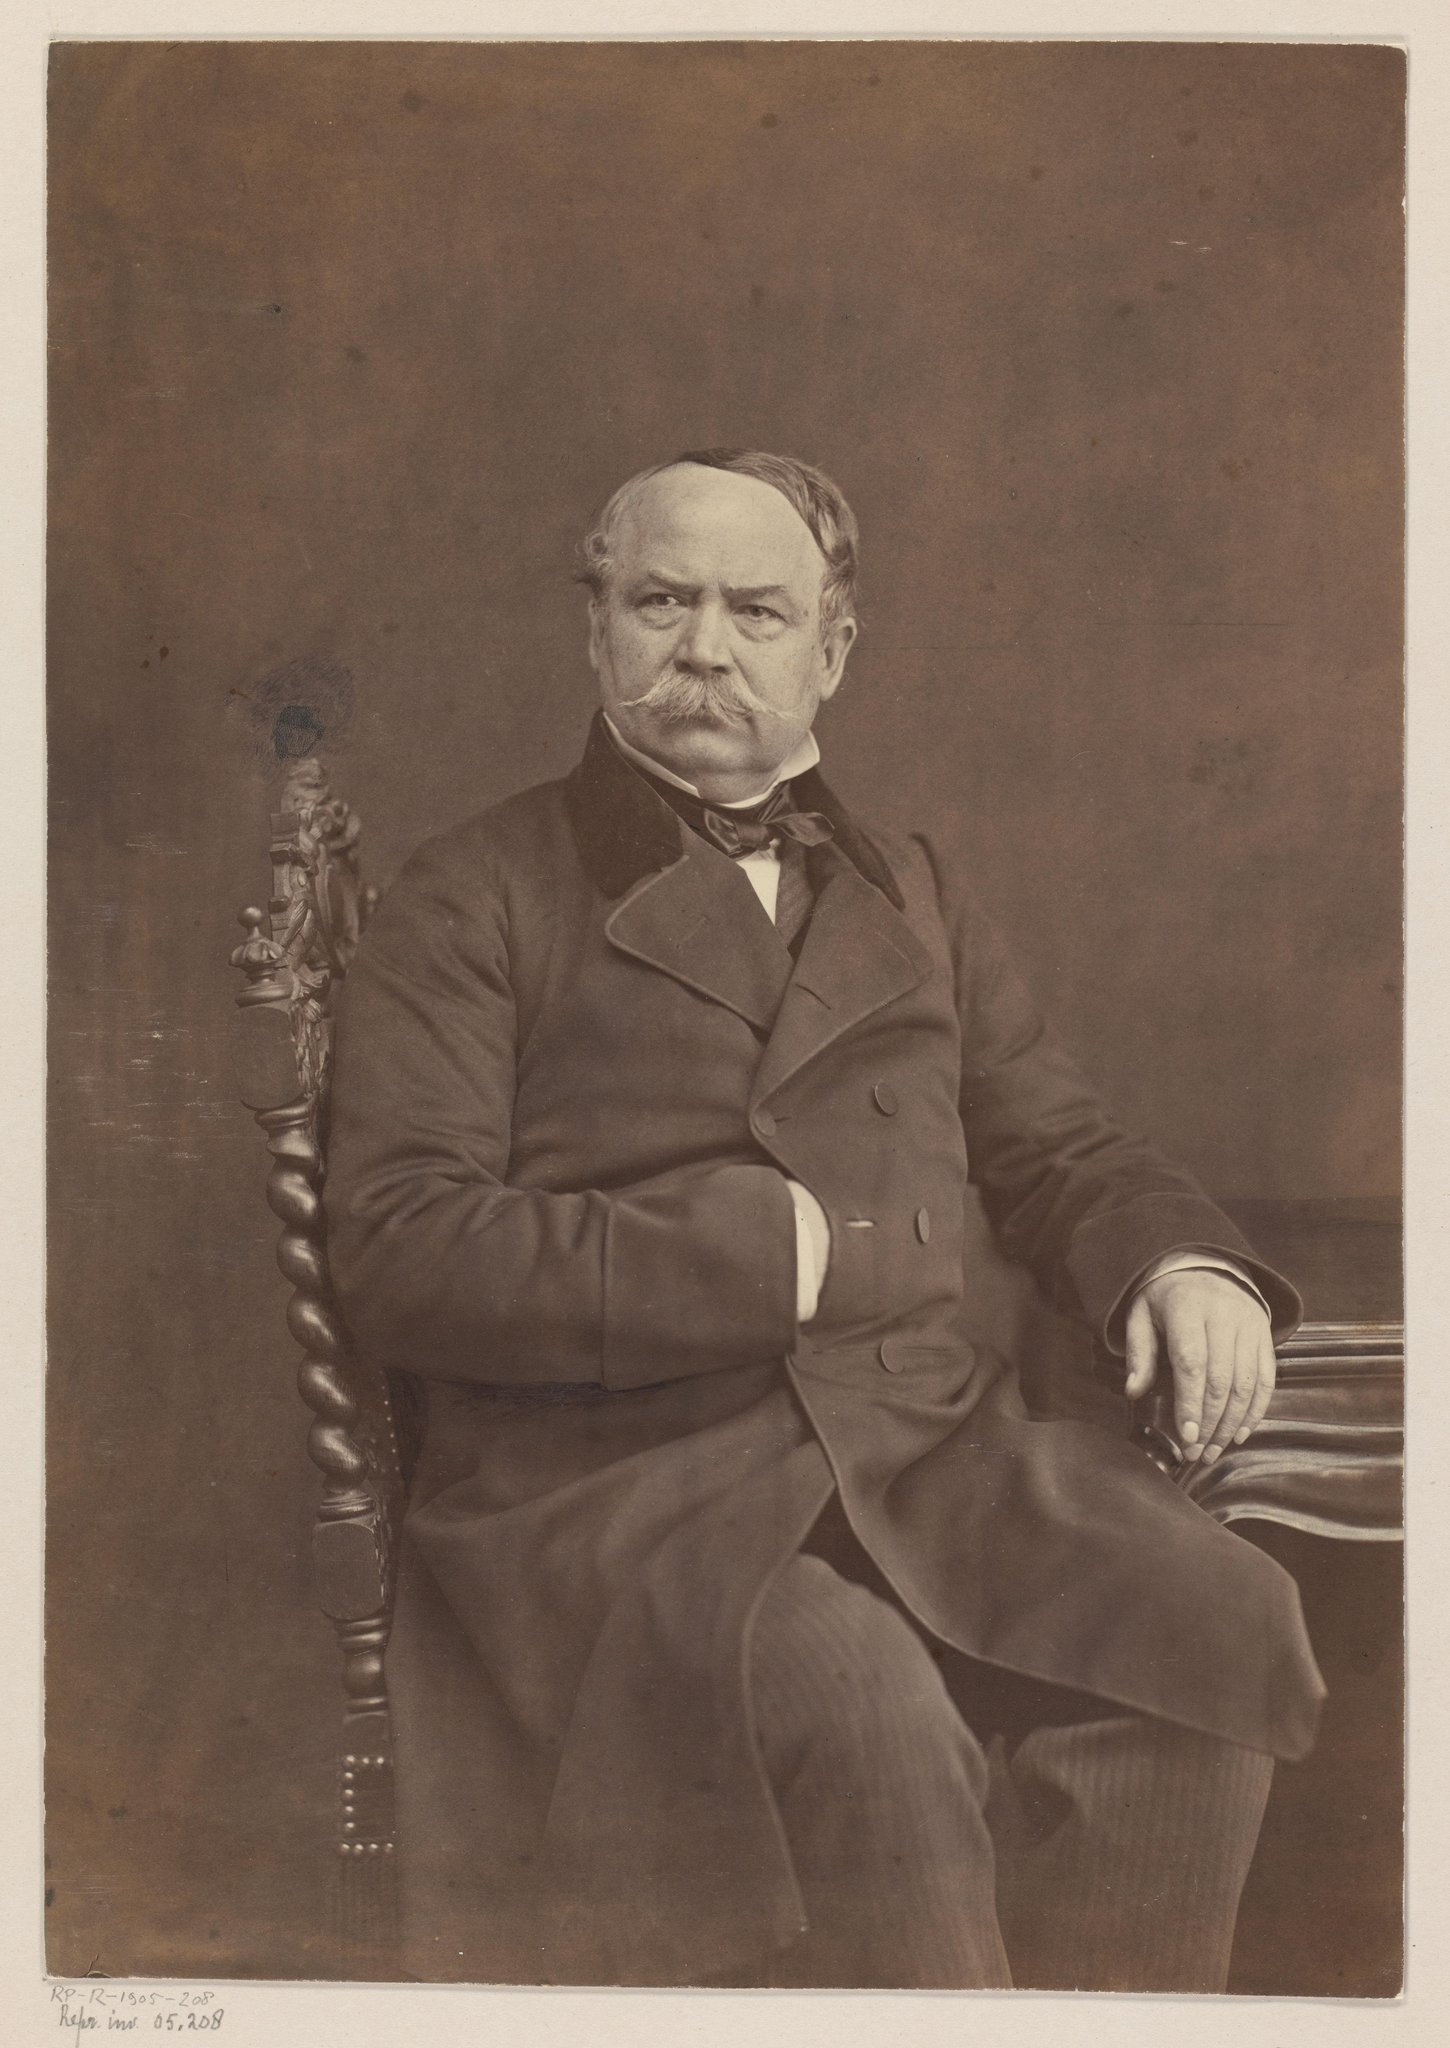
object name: photograph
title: Portret van Marian Płachecki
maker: Anonymous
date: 1862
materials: cardboard, paper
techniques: albumen print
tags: historical persons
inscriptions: collector's mark: Lugt 2228